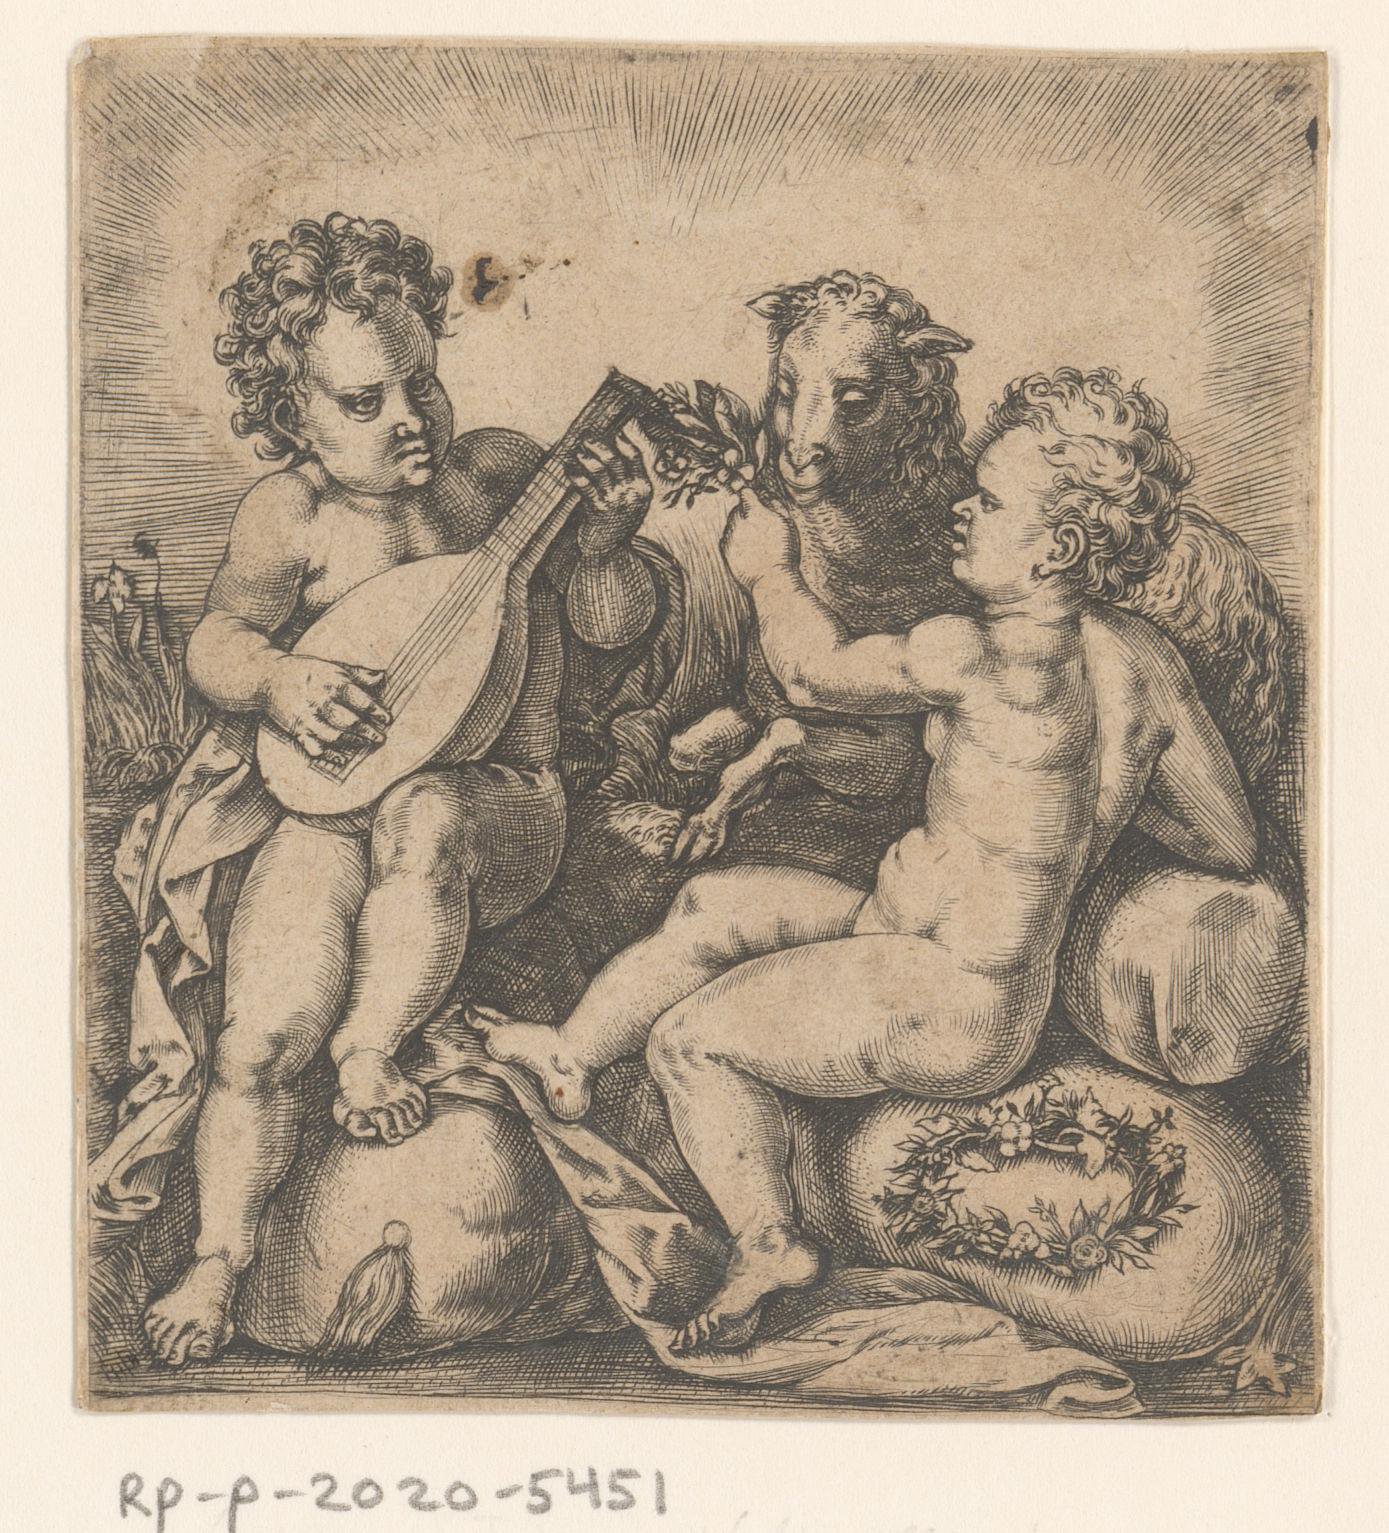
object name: print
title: Twee jongens met luit en bloemen bij een lam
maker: Anonymous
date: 1540-1599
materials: paper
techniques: engraving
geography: italy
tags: cut flowers; nosegay, bunch of flowers, lamb, lute, and special forms of lute, e.g.: theorbo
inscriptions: collector's mark: Lugt 2228, collector's mark: Lugt 1704